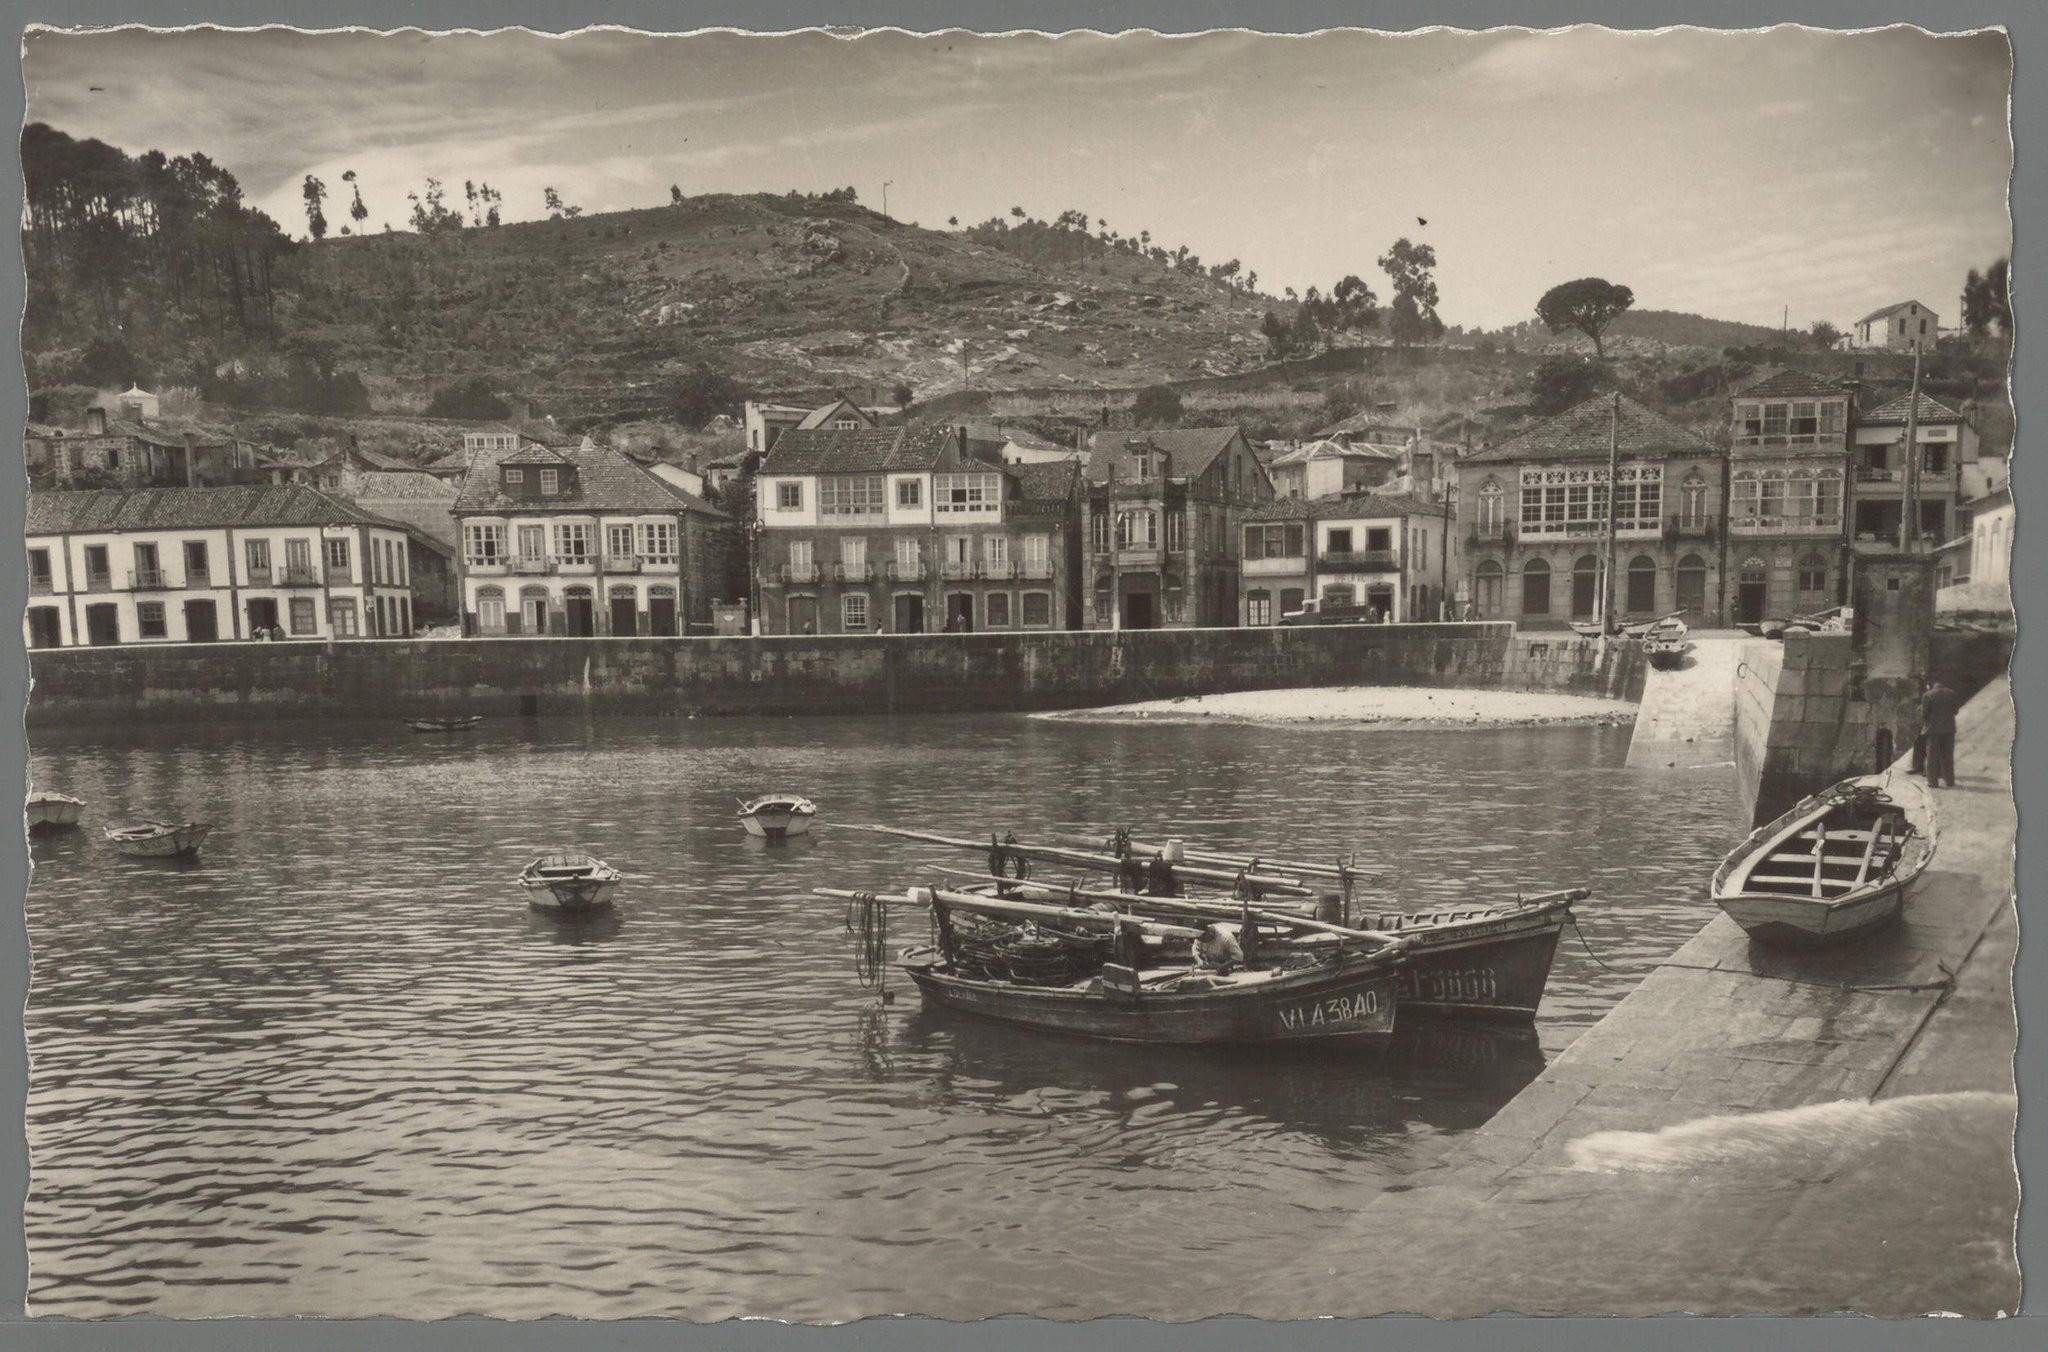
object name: ansichtkaart, prentbriefkaart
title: Bayona (Pontevedra). Puerto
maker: luis garcía garrabella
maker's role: publisher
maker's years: -1977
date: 1939-1950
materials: photographic support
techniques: photography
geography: zaragoza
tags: harbour, prospect of village, silhouette of village